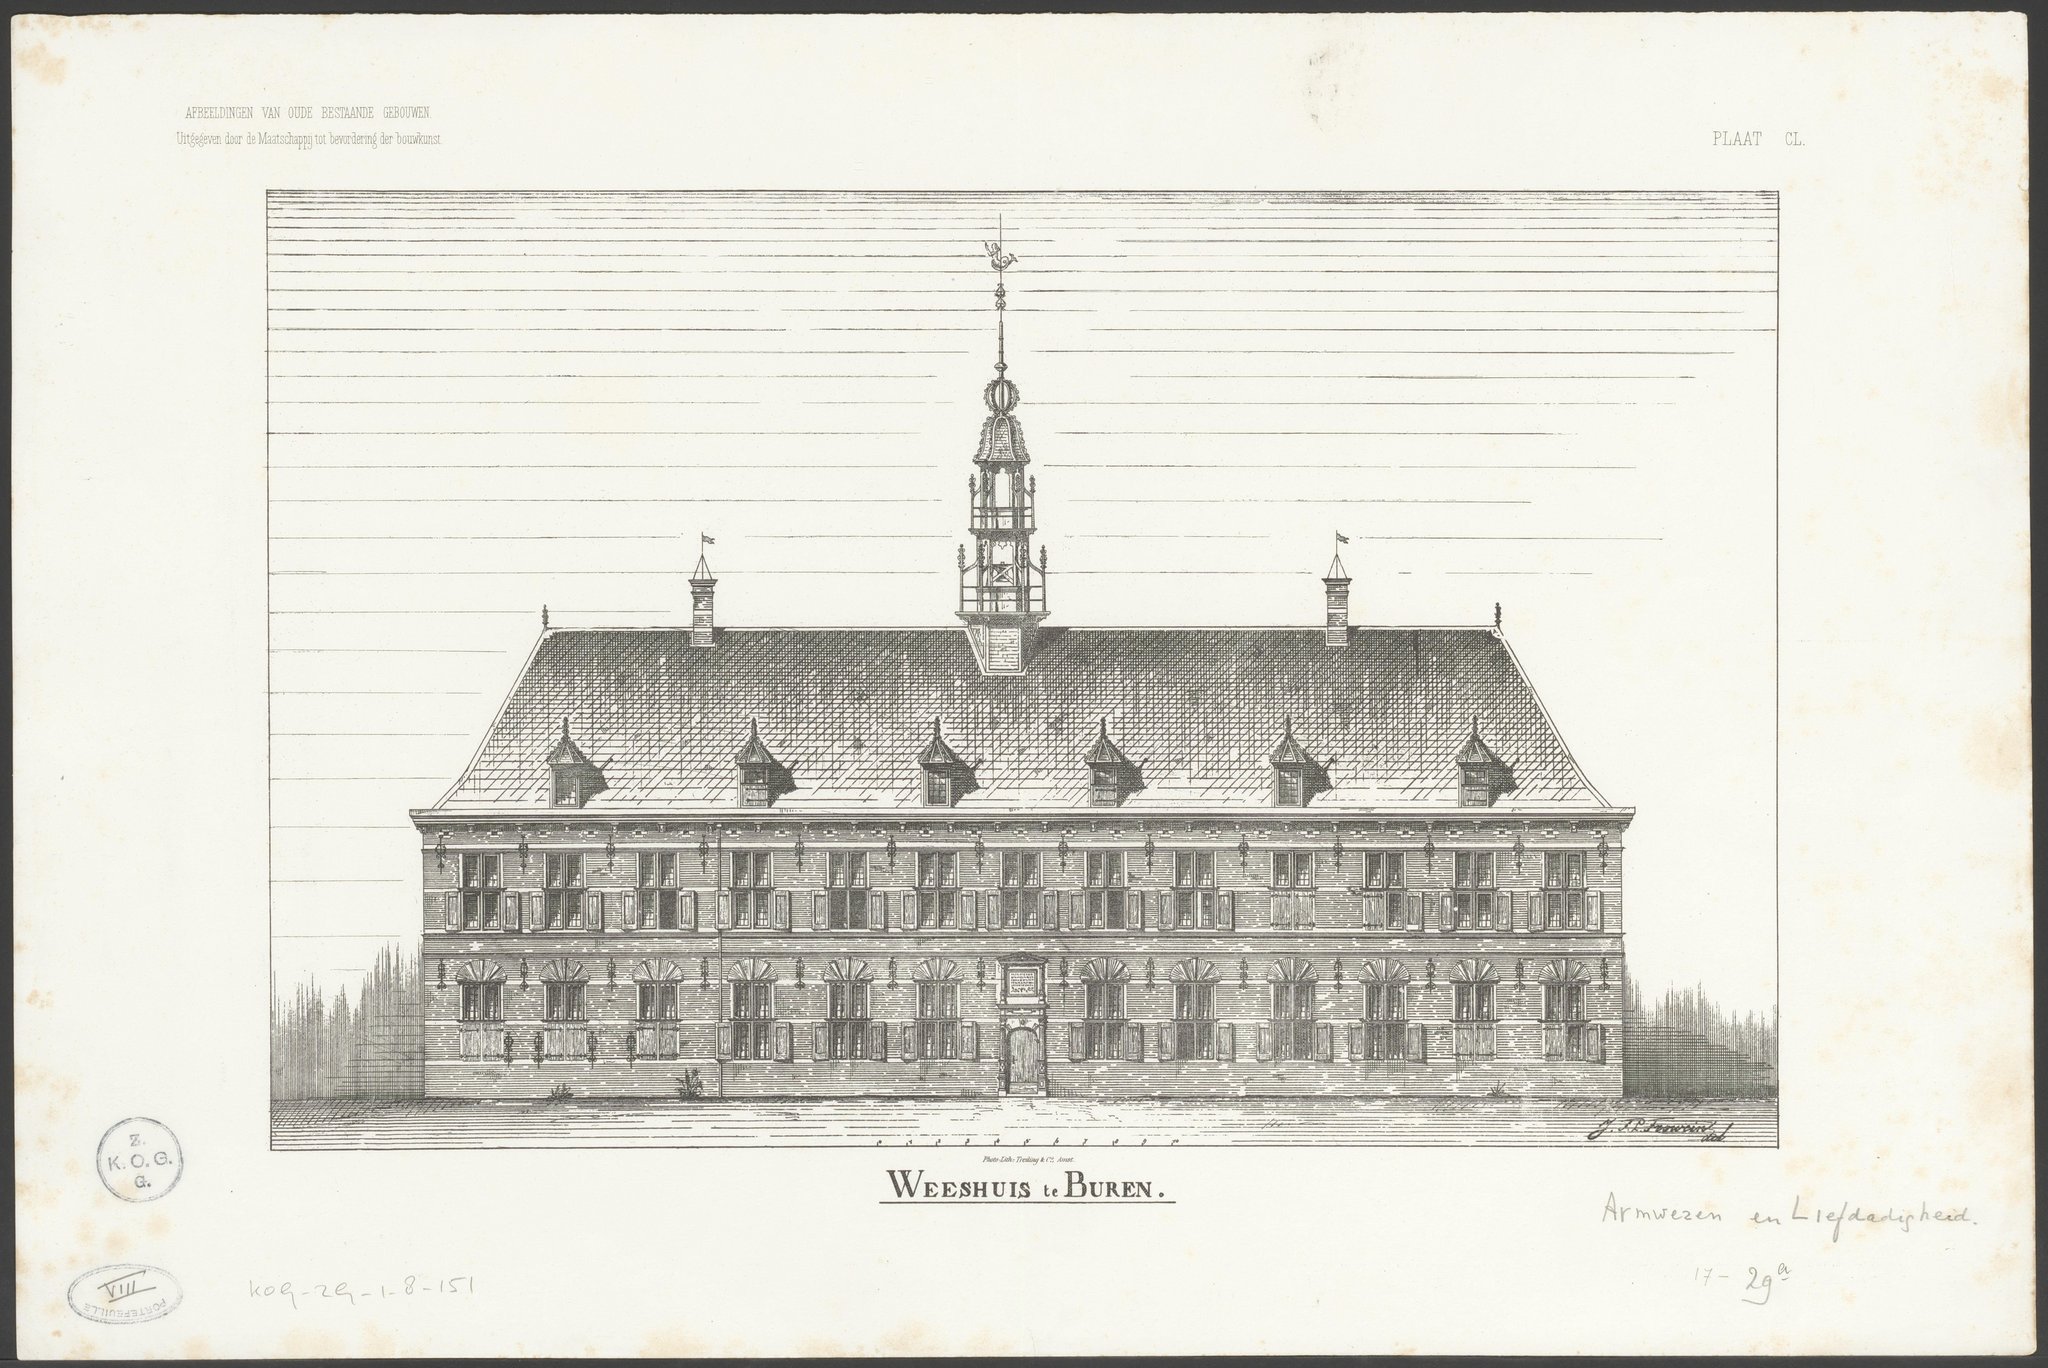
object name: photomechanical print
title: Weeshuis te Buren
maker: jan frederik lodewijk frowein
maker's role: draughtsman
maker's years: 1855-1914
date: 1870-1907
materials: paper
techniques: photolithography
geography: amsterdam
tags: orphanage, front façade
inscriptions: collector's mark: Lugt 1641, collector's mark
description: Aanzicht van de weeshuis te Buren. Onderaan een schaalstok. Architectuurvoorstelling. Plaat CL. Onderwerpsrubrieken binnen de Atlas Zeden en Gewoonten: Armwezen en Liefdadigheid.